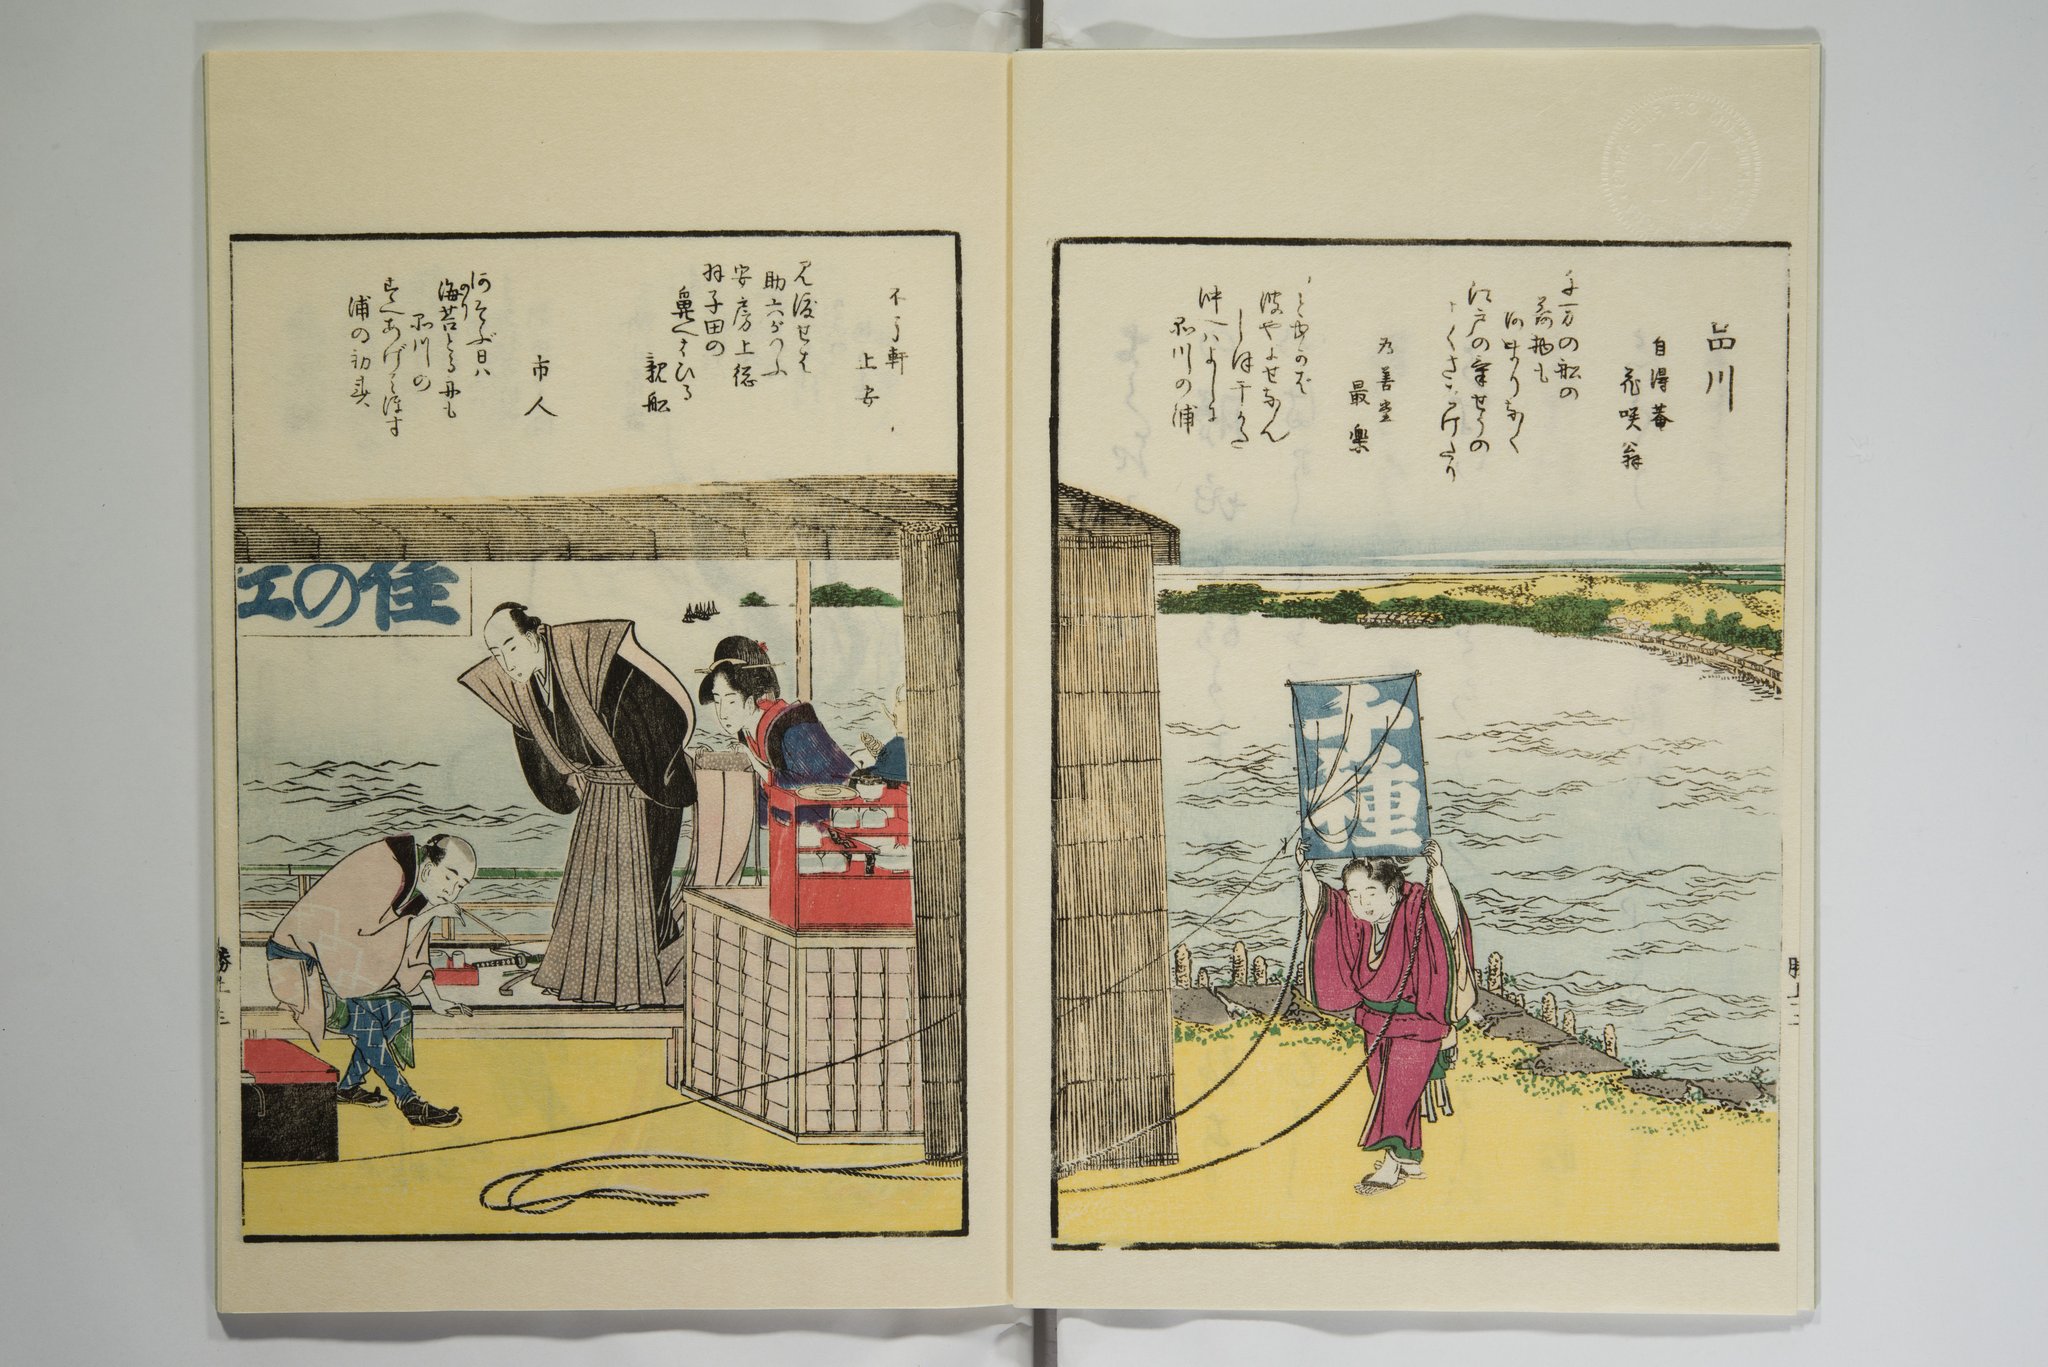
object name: illustrated book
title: Sites of the Eastern Capital at a Glance (Tōto shōkei ichiran), facsimile version by the Museum of Fine Arts Boston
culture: japanese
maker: katsushika hokusai 葛飾北斎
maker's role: artist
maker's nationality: japanese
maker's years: 1760-1849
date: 1901-2000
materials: ink, paper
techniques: woodblock print